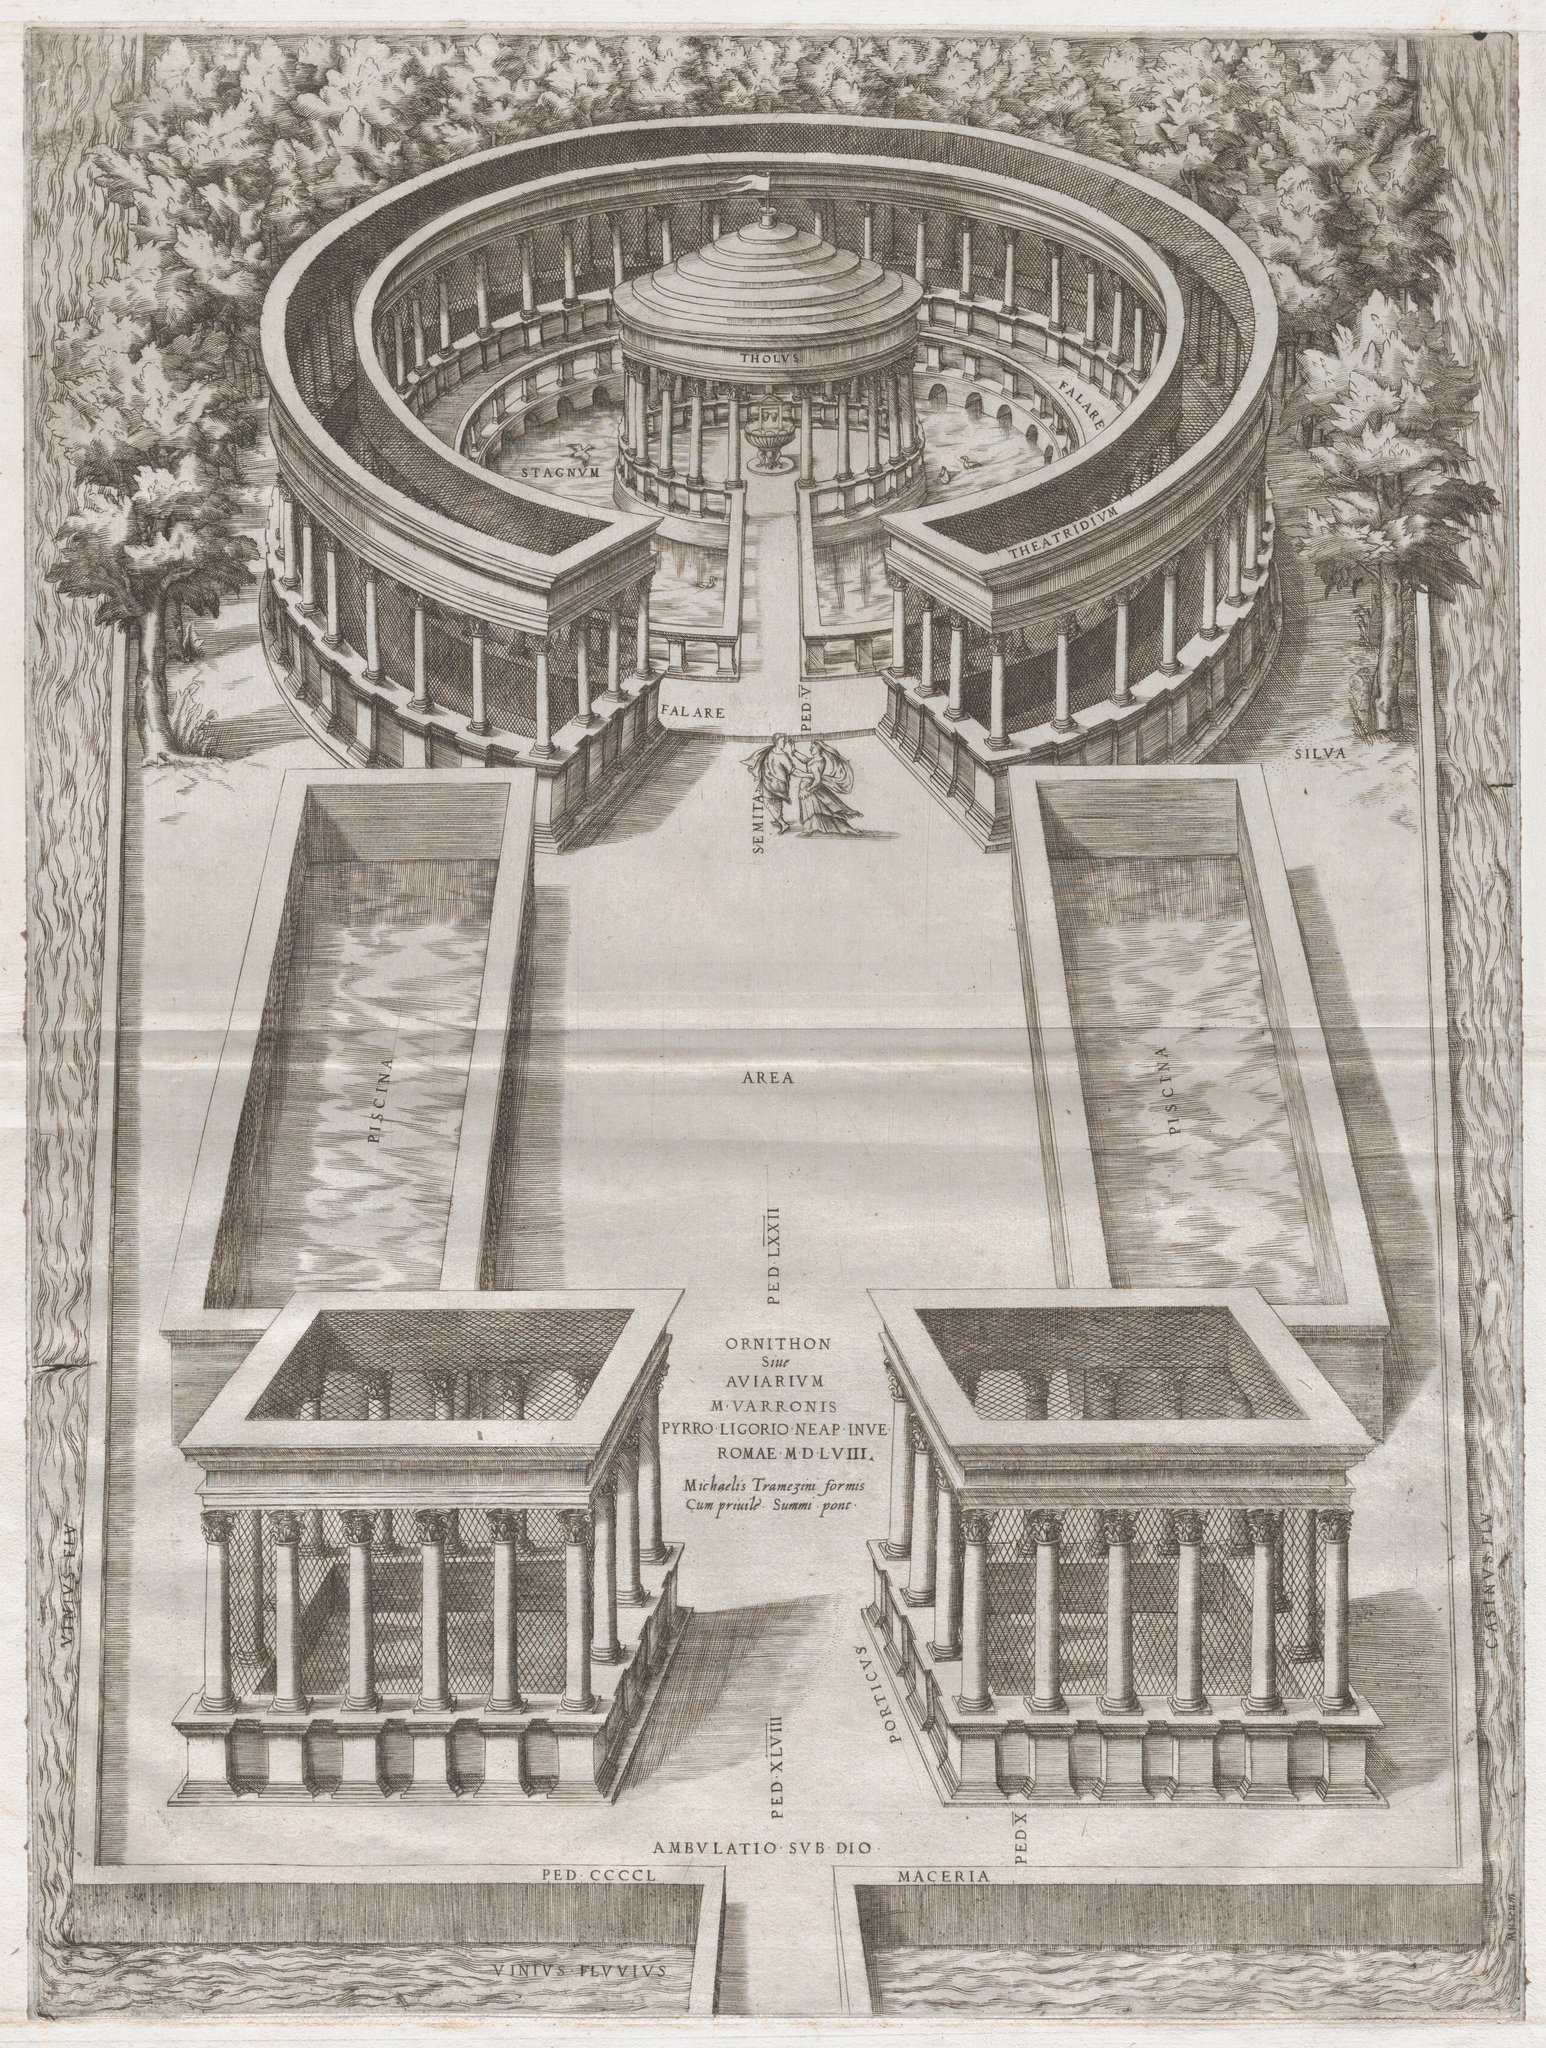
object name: print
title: Ornithon Sive Aviarum, from "Speculum Romanae Magnificentiae"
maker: Anonymous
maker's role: artist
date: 1558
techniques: etching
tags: architecture,rome